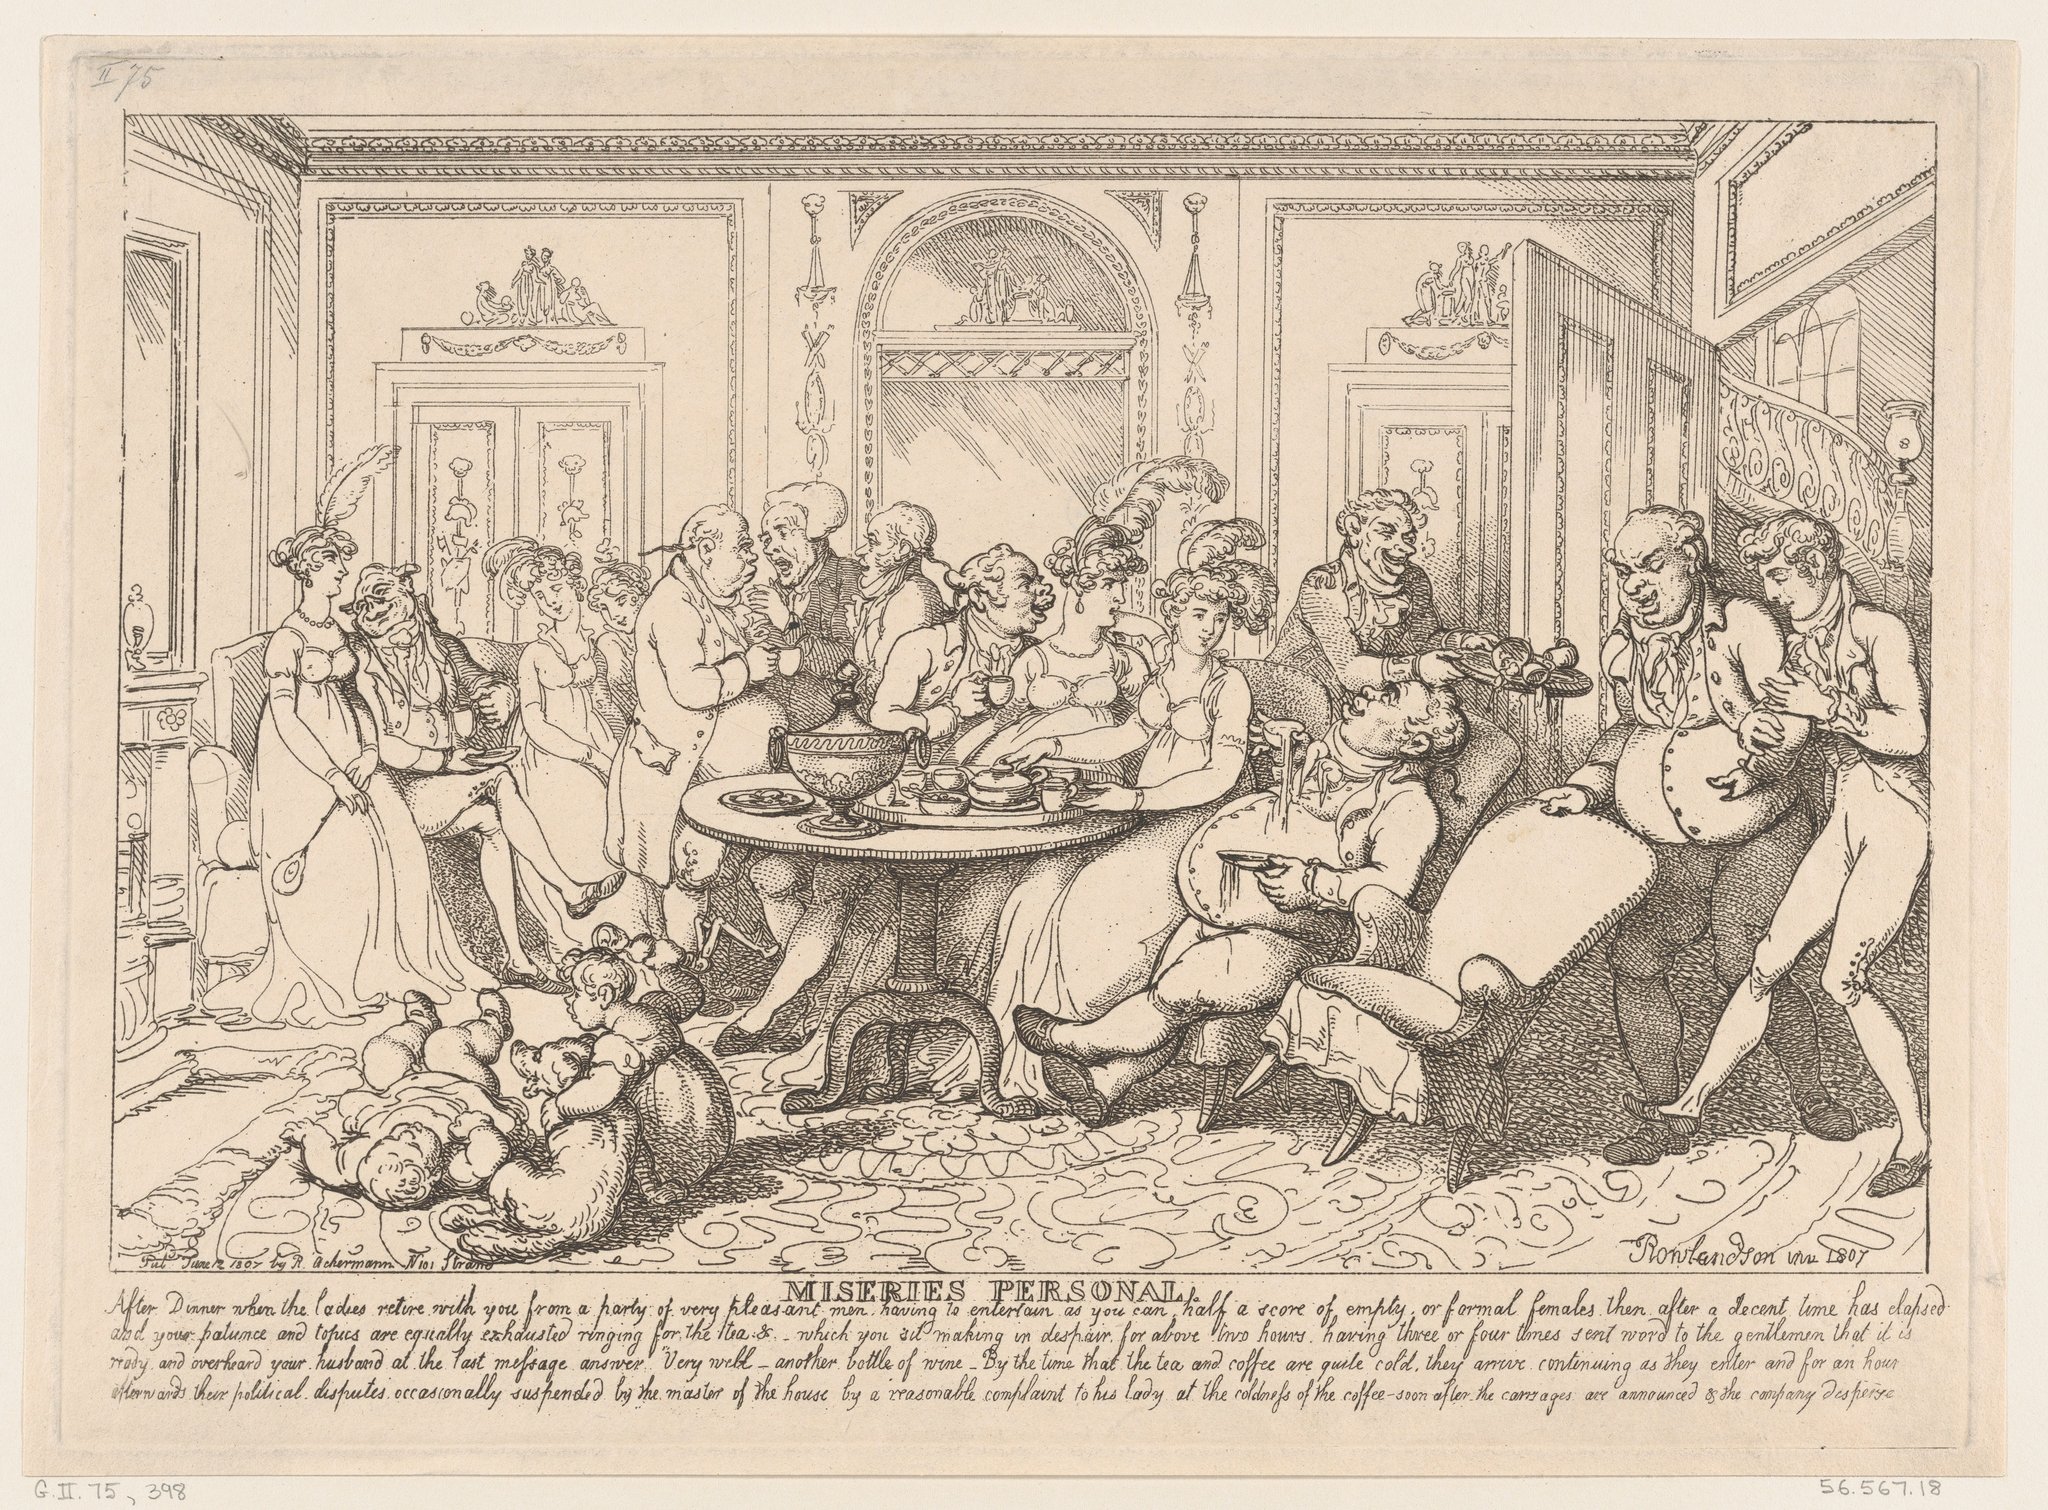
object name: print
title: Miseries Personal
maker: thomas rowlandson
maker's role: artist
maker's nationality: british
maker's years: 1757-1827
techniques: etching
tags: men,women,dogs,dining,drinking